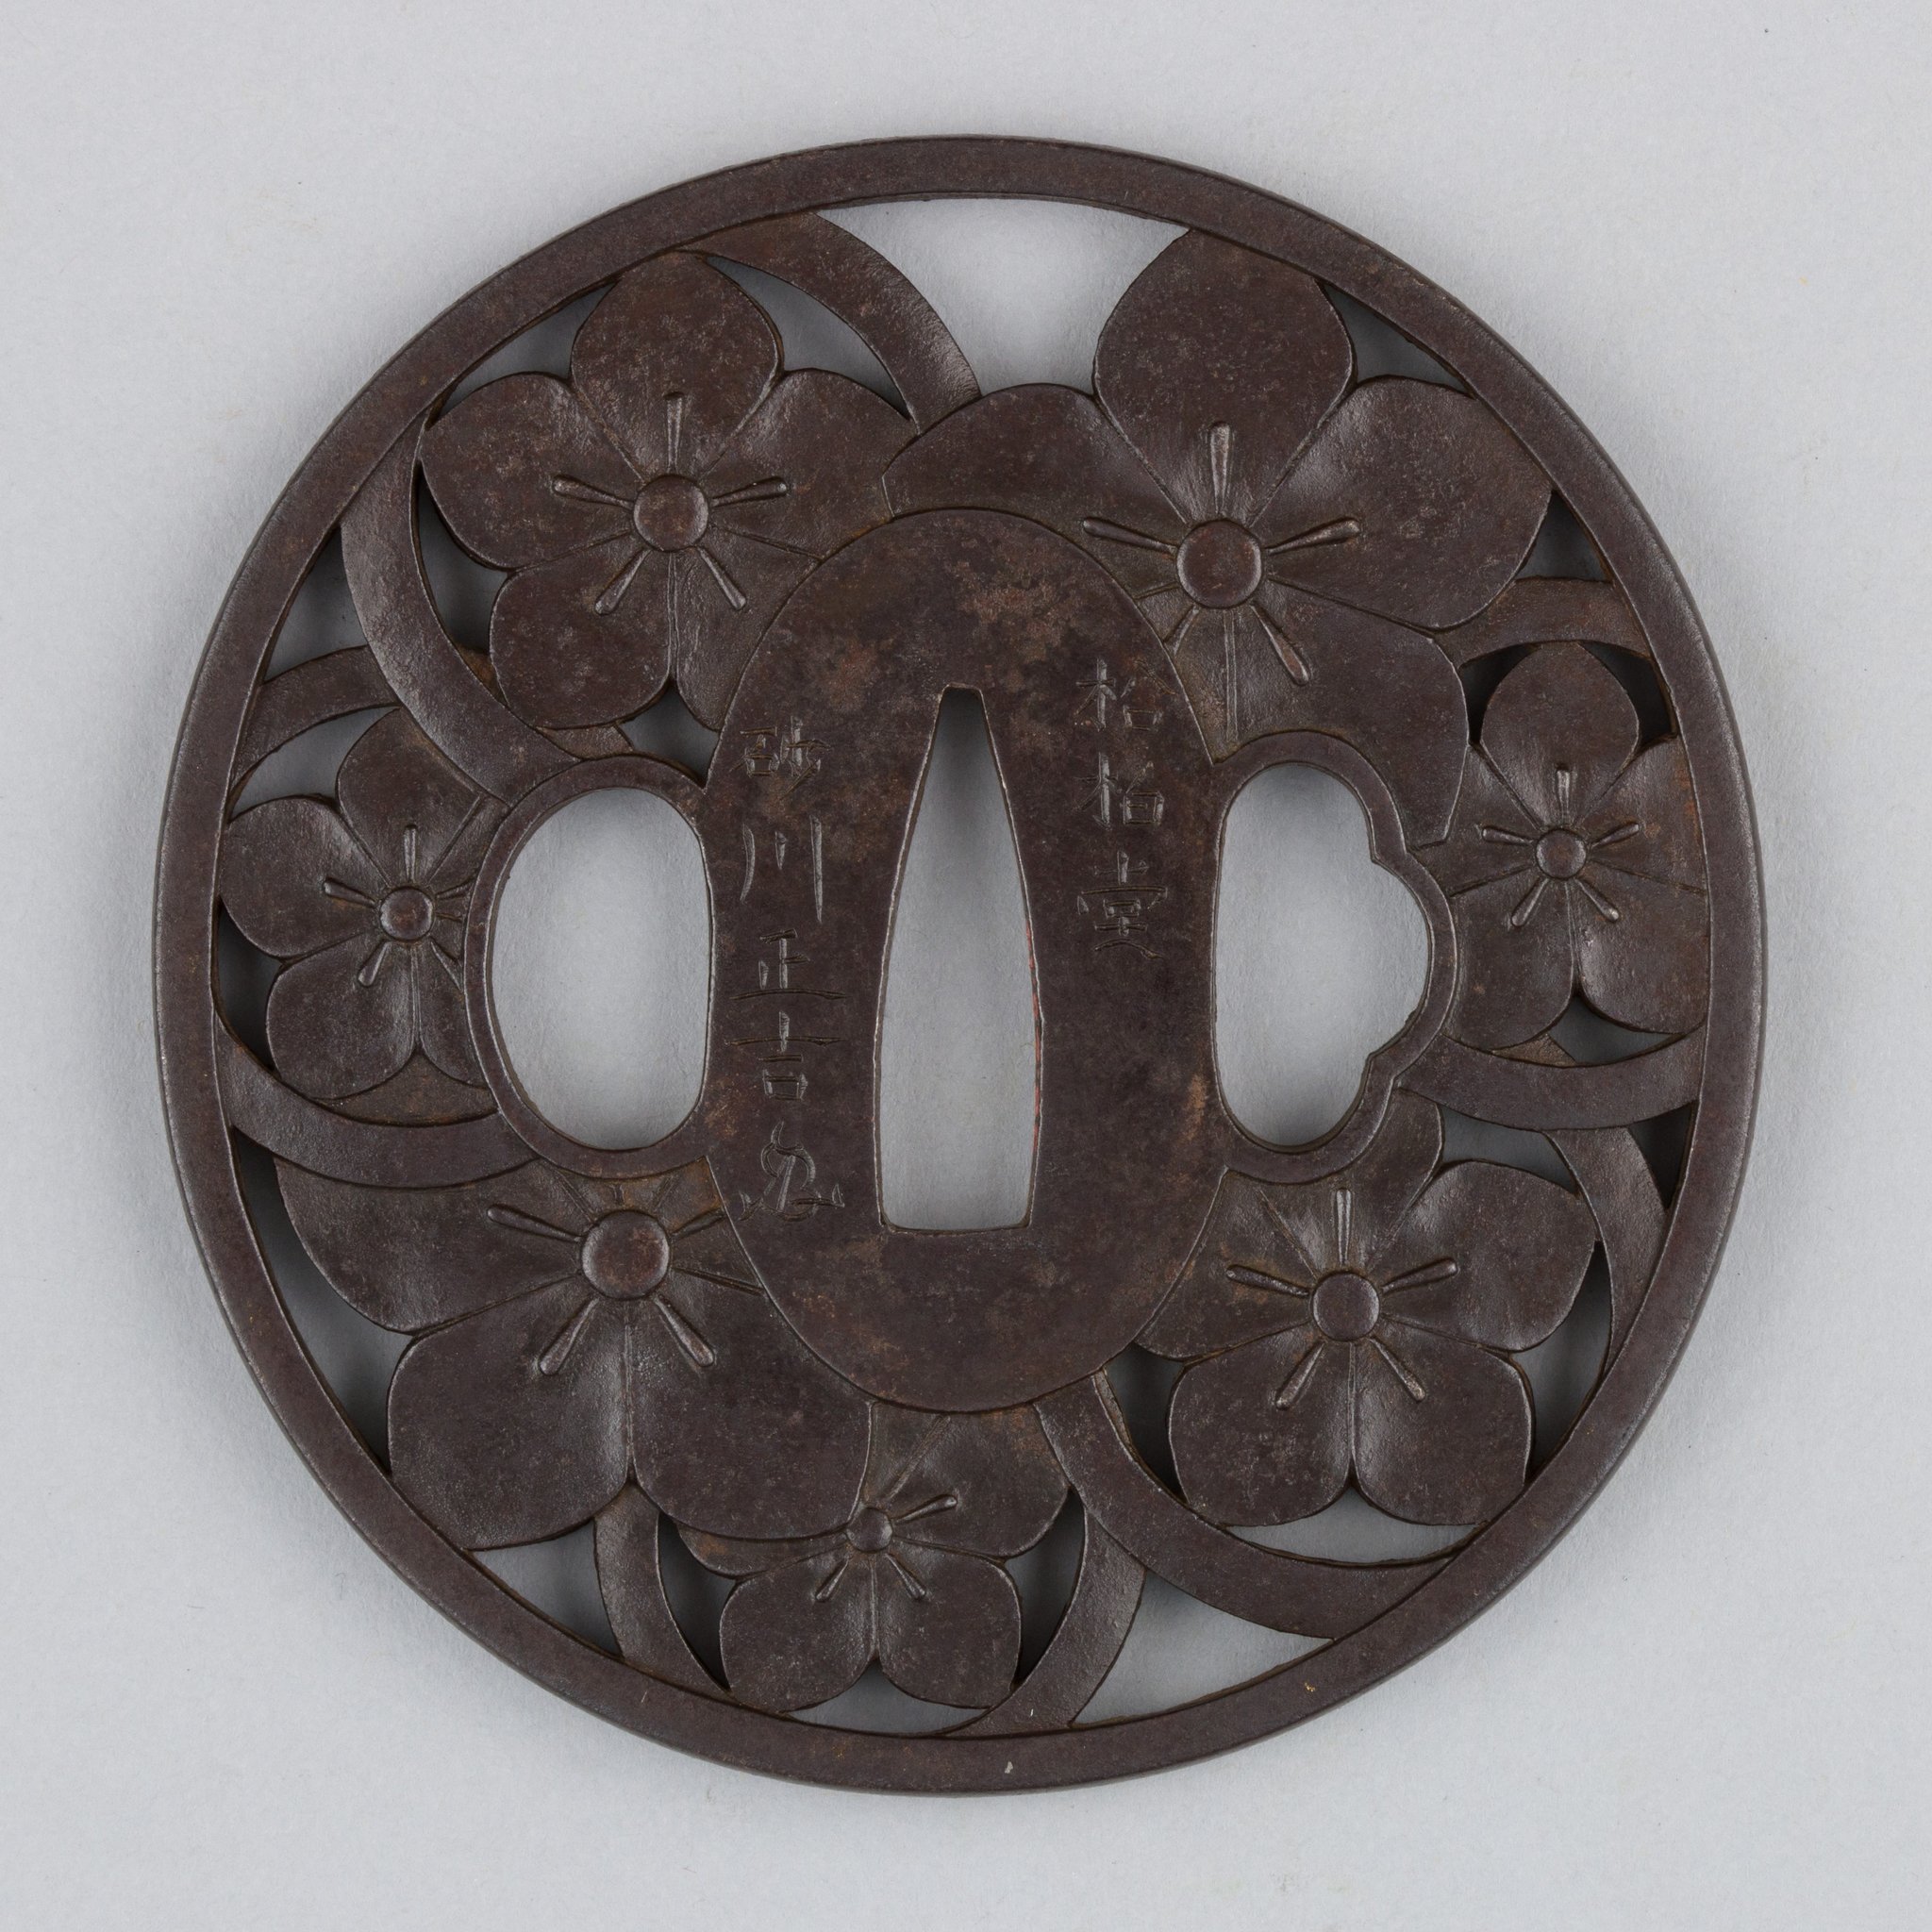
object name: sword guard tsuba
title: Sword Guard (Tsuba)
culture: japanese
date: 1801-1833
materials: iron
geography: japan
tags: flowers